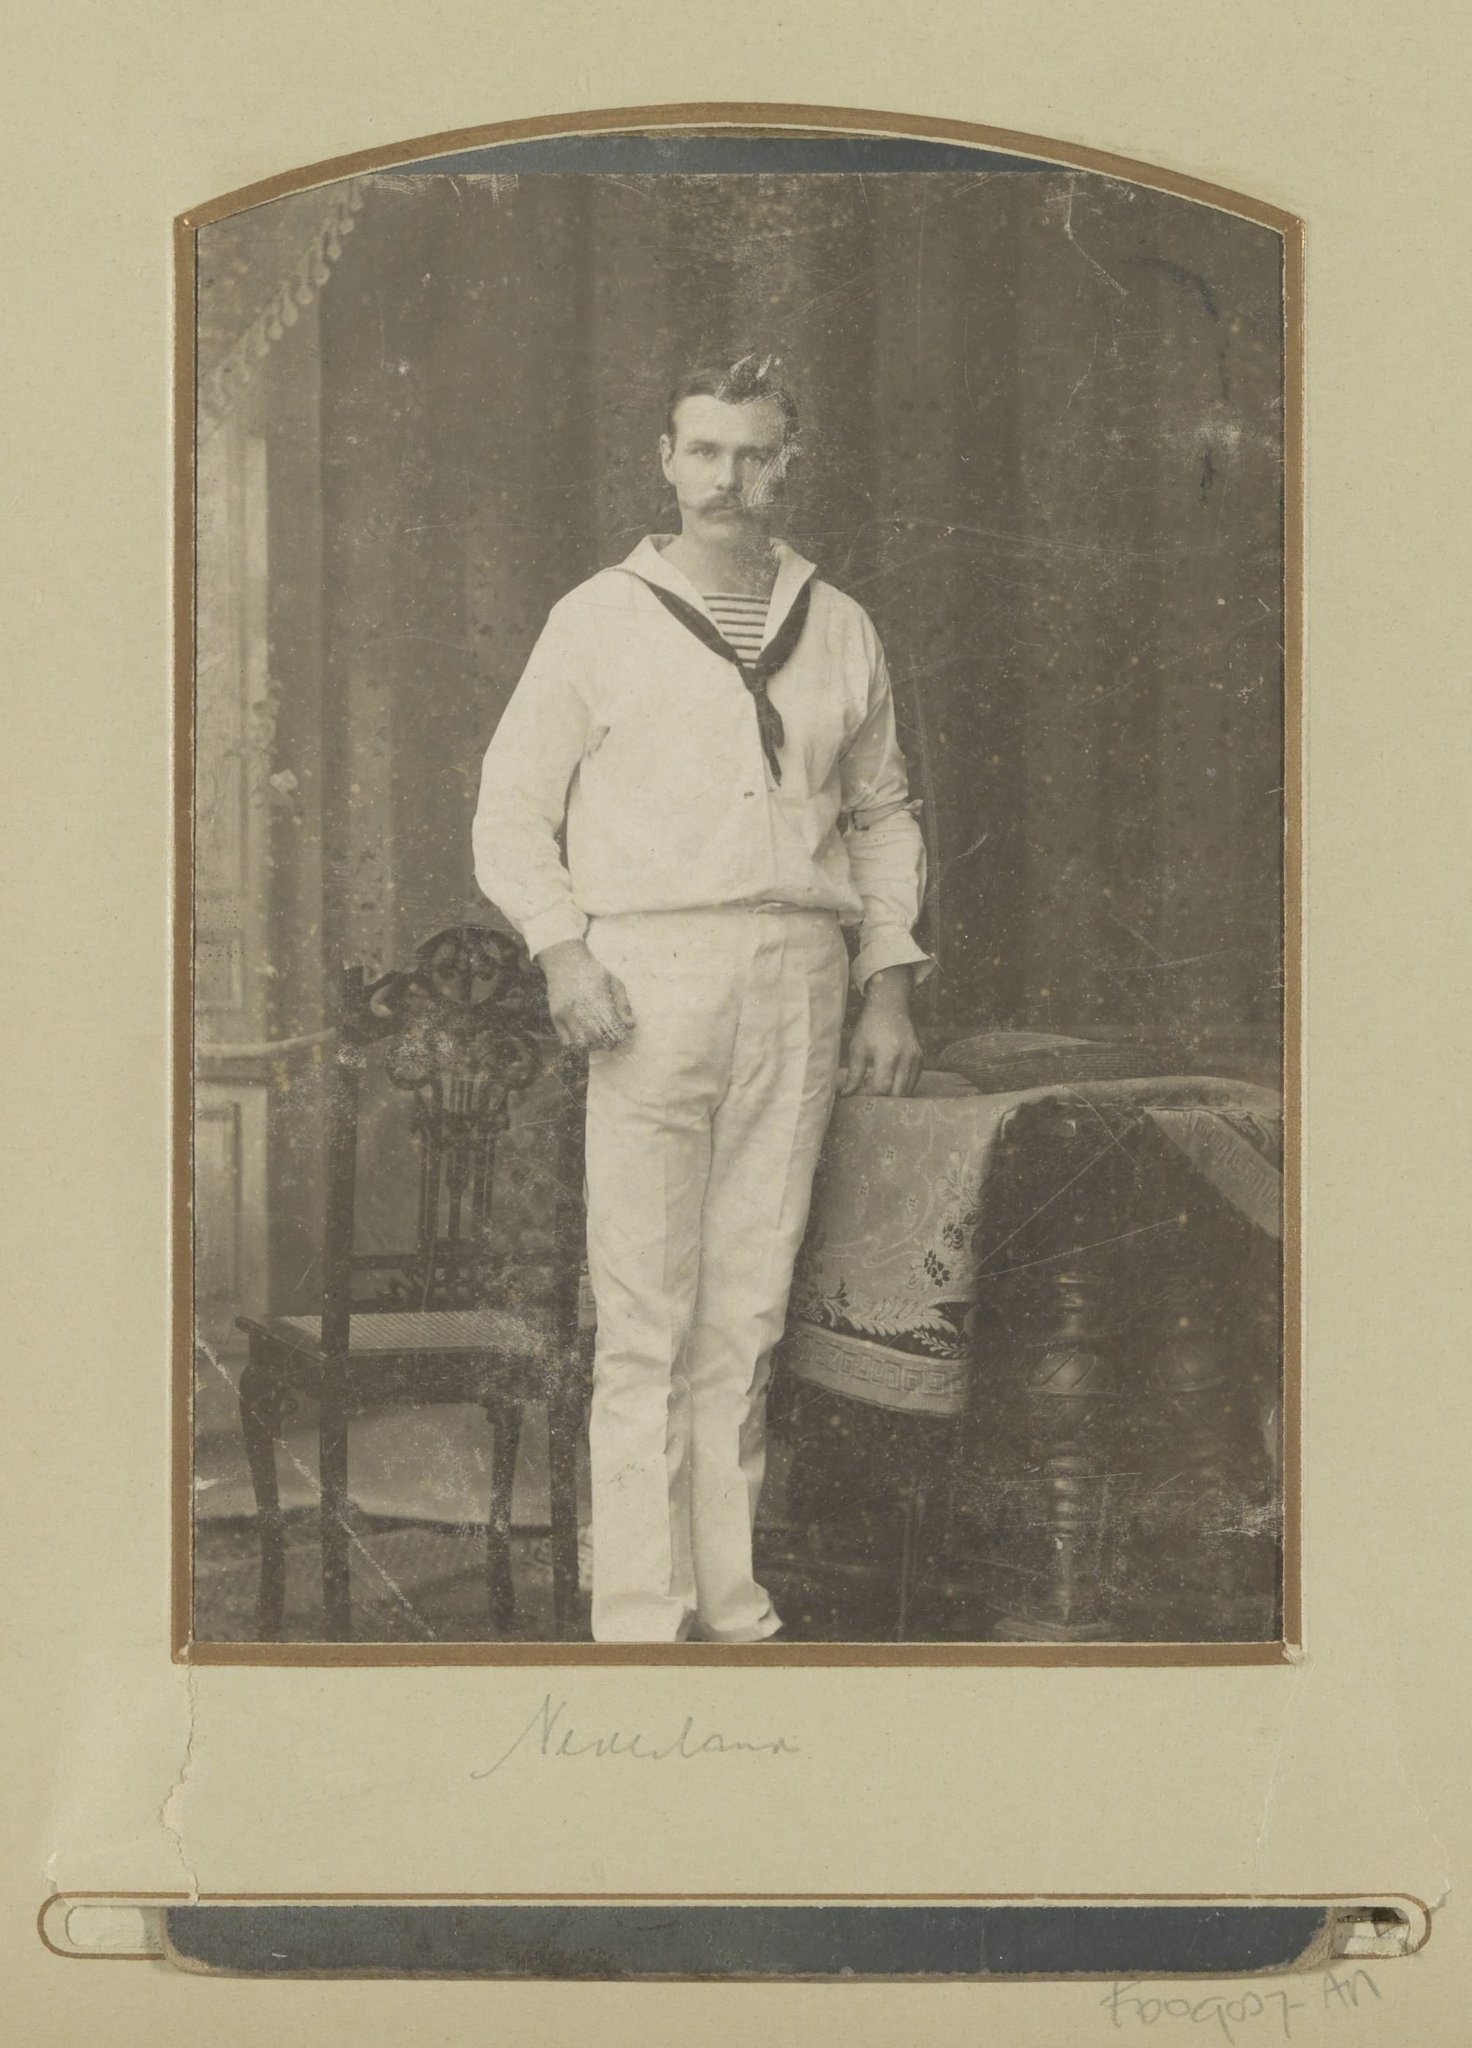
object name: photograph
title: Portret van een matroos, staand bij een tafel, vermoedelijk in Soerabaja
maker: Anonymous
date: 1870-1900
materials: cardboard, paper, photographic support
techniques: albumen print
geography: surabaya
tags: studio requisites ~ photographer, navy, warfare; military affairs, (military) uniforms, division of armed forces, surabaya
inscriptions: inscription: ‘[...]OERABAIA’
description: Onderdeel van Album met cartes-de-visite en kabinetfoto's van militairen in uniform.